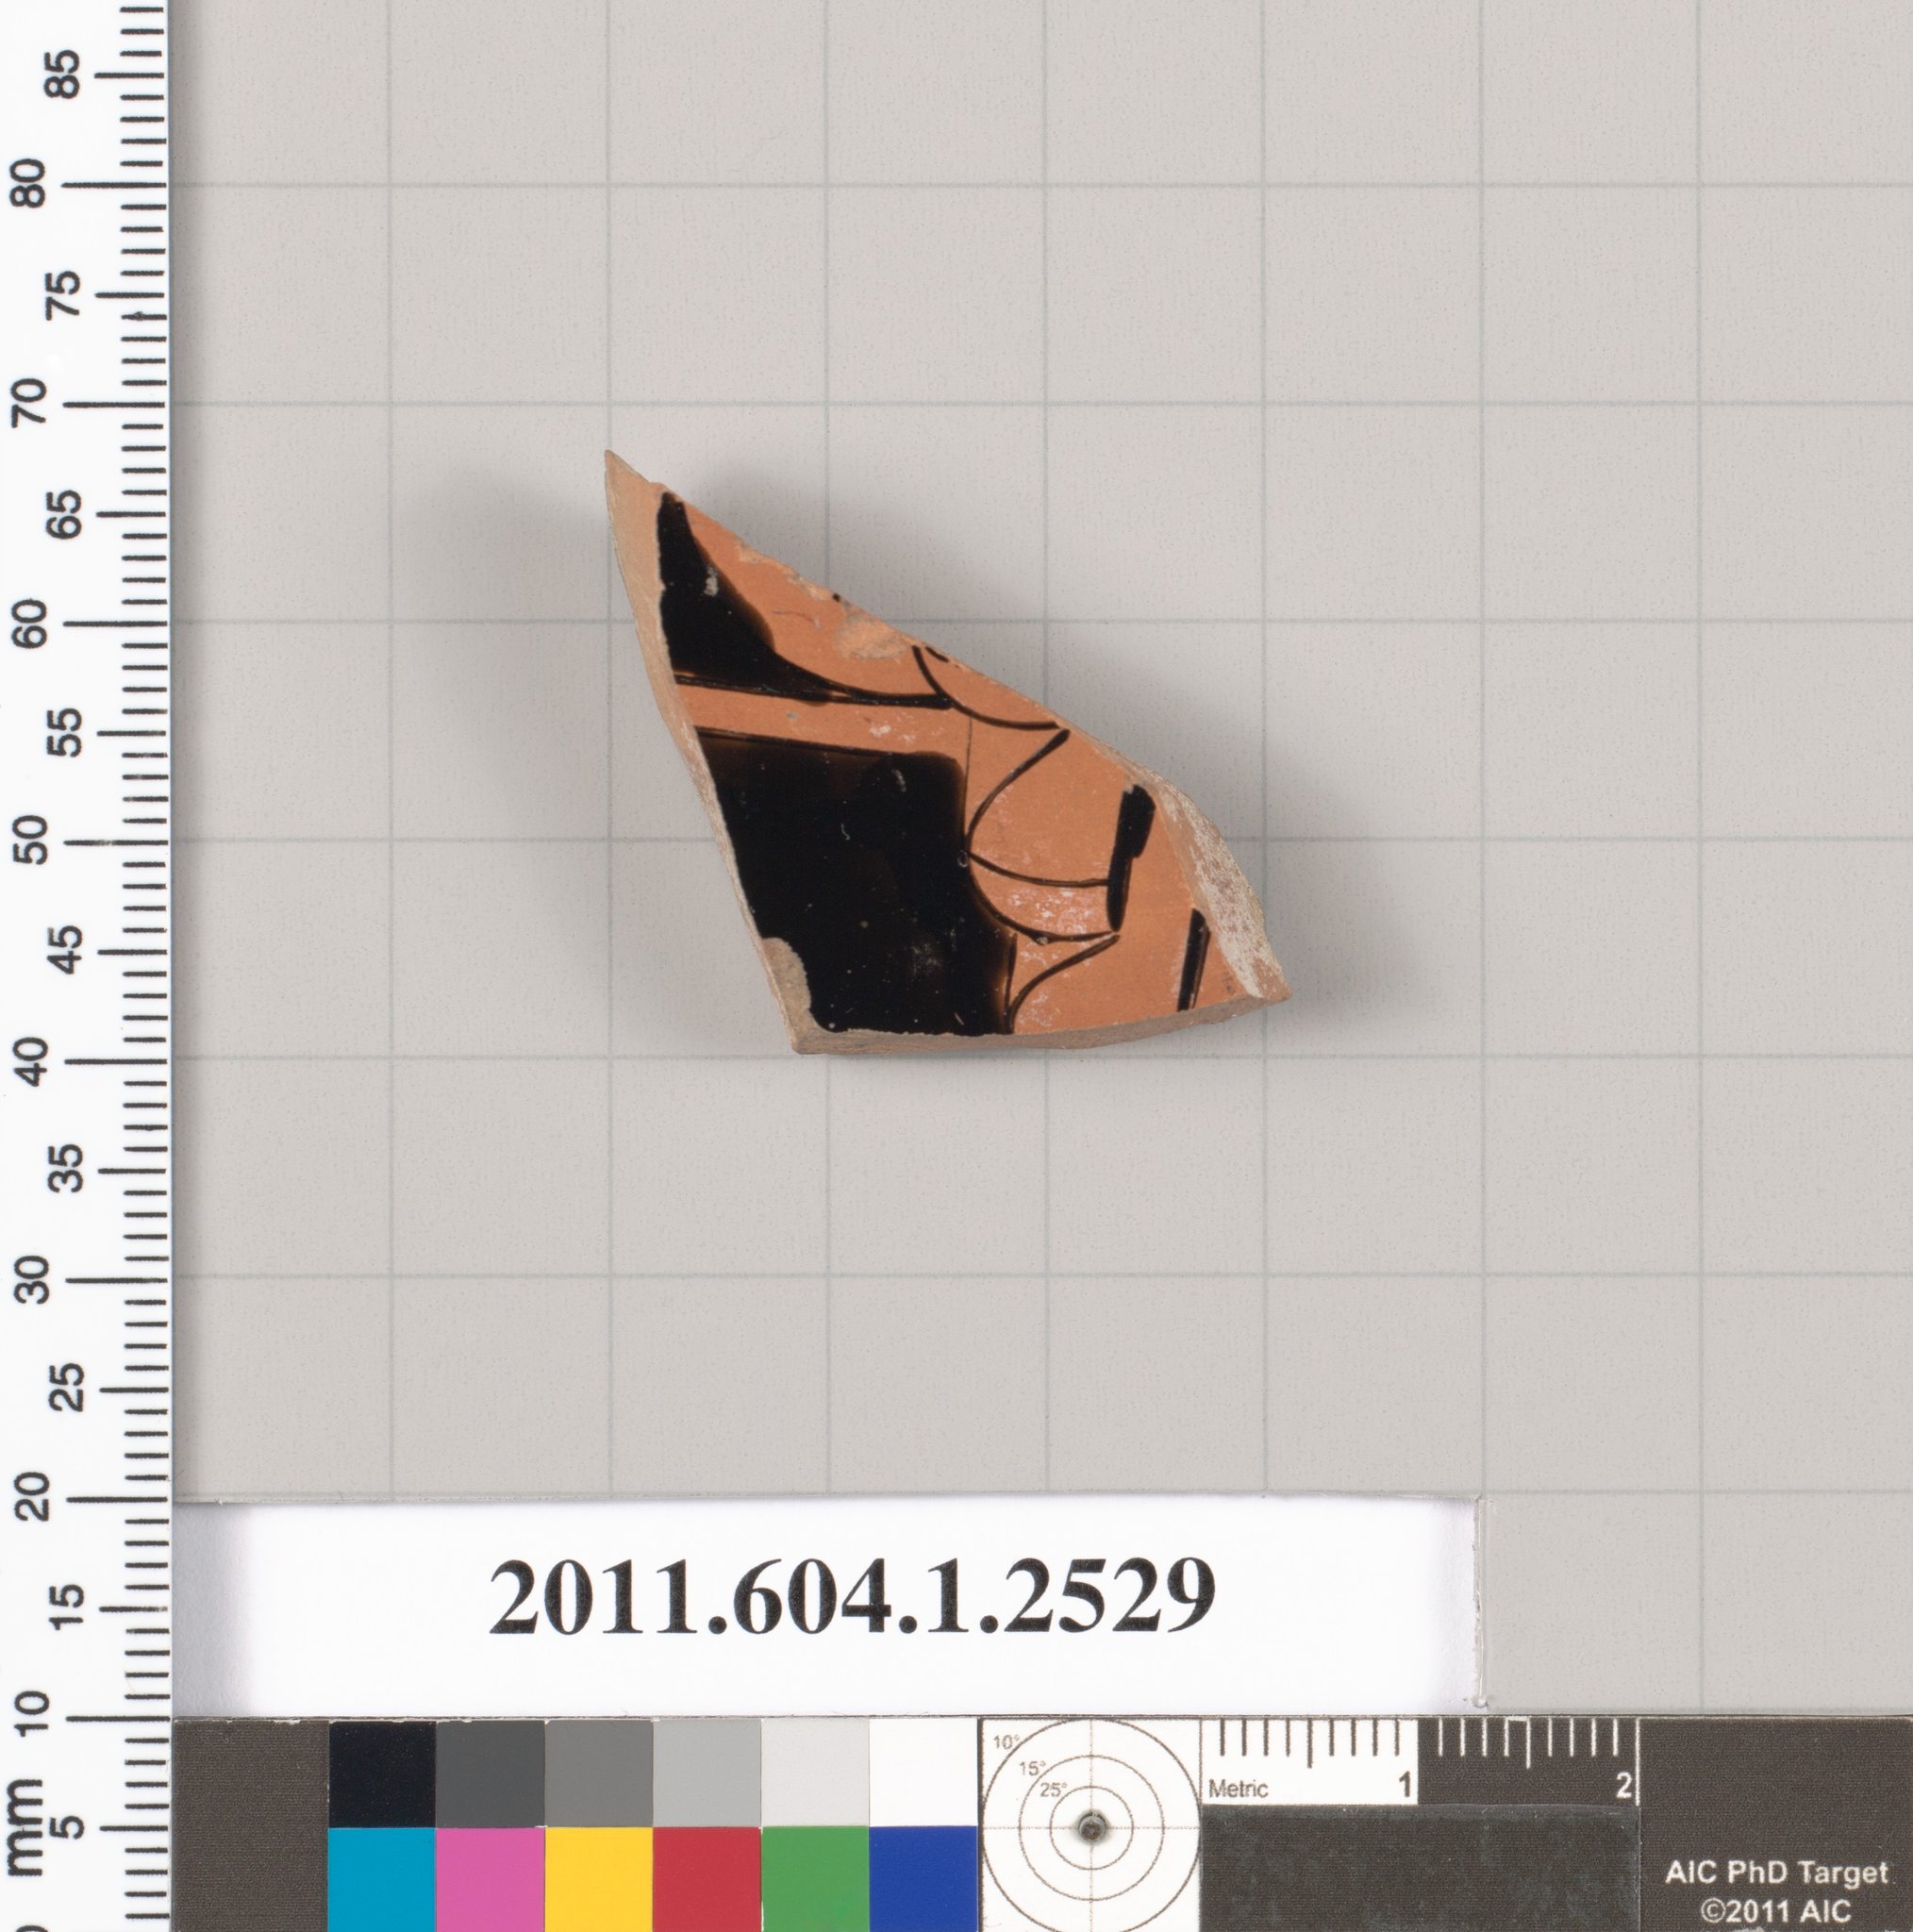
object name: kylix fragment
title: Terracotta fragment of a kylix (drinking cup)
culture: greek, attic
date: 490-480 BCE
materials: terracotta